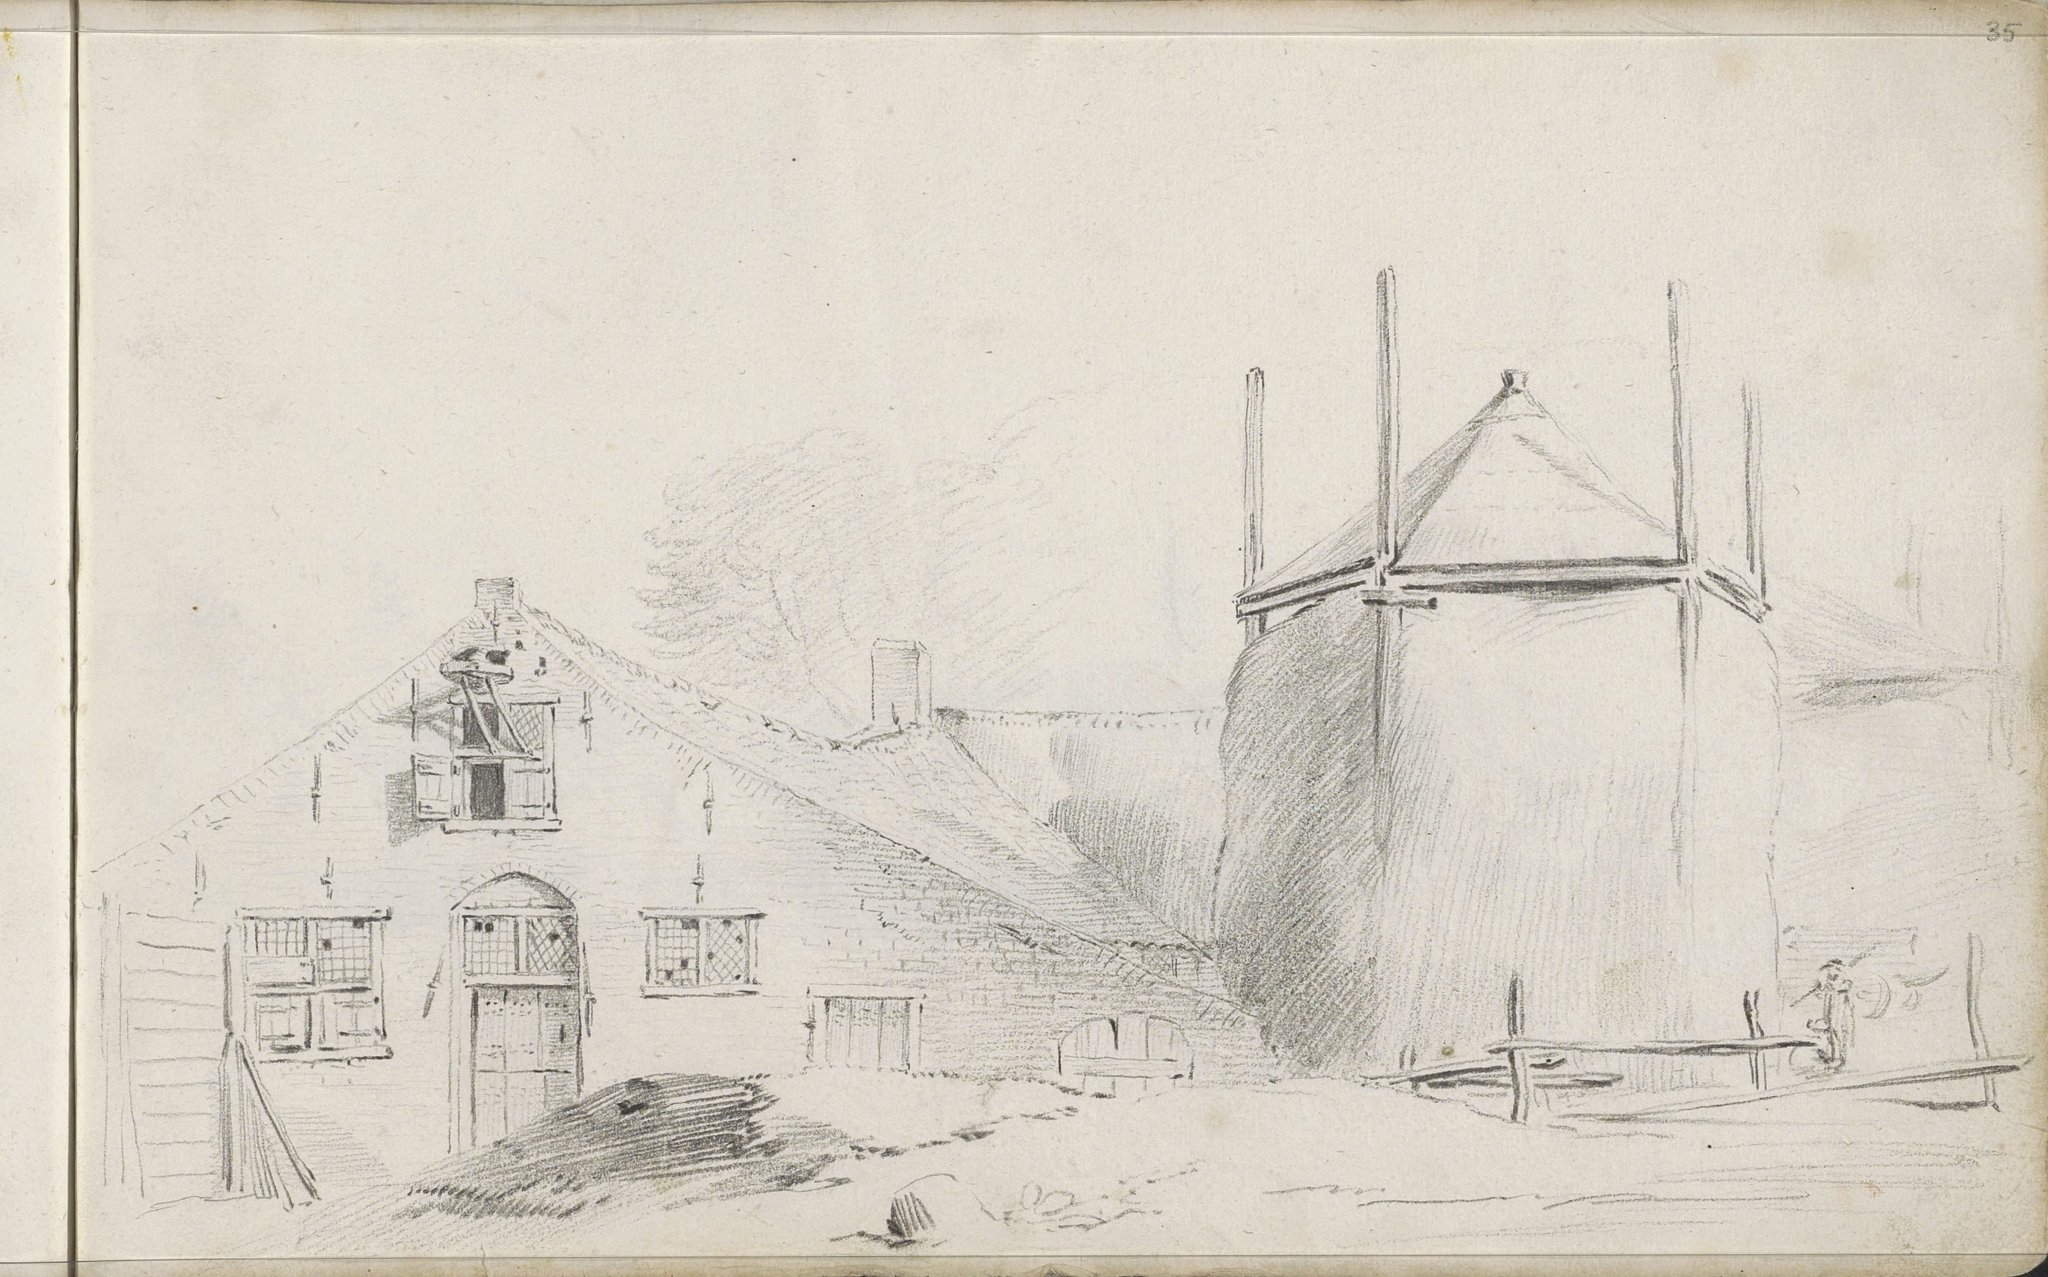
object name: sketchbook leaf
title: Boerenerf met hooimijt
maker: pieter moninckx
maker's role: draughtsman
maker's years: 1606-1686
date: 1645-1646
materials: chalk, paper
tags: hay-stack, farm (building)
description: Blad 35 recto uit een schetsboek met 39 bladen.